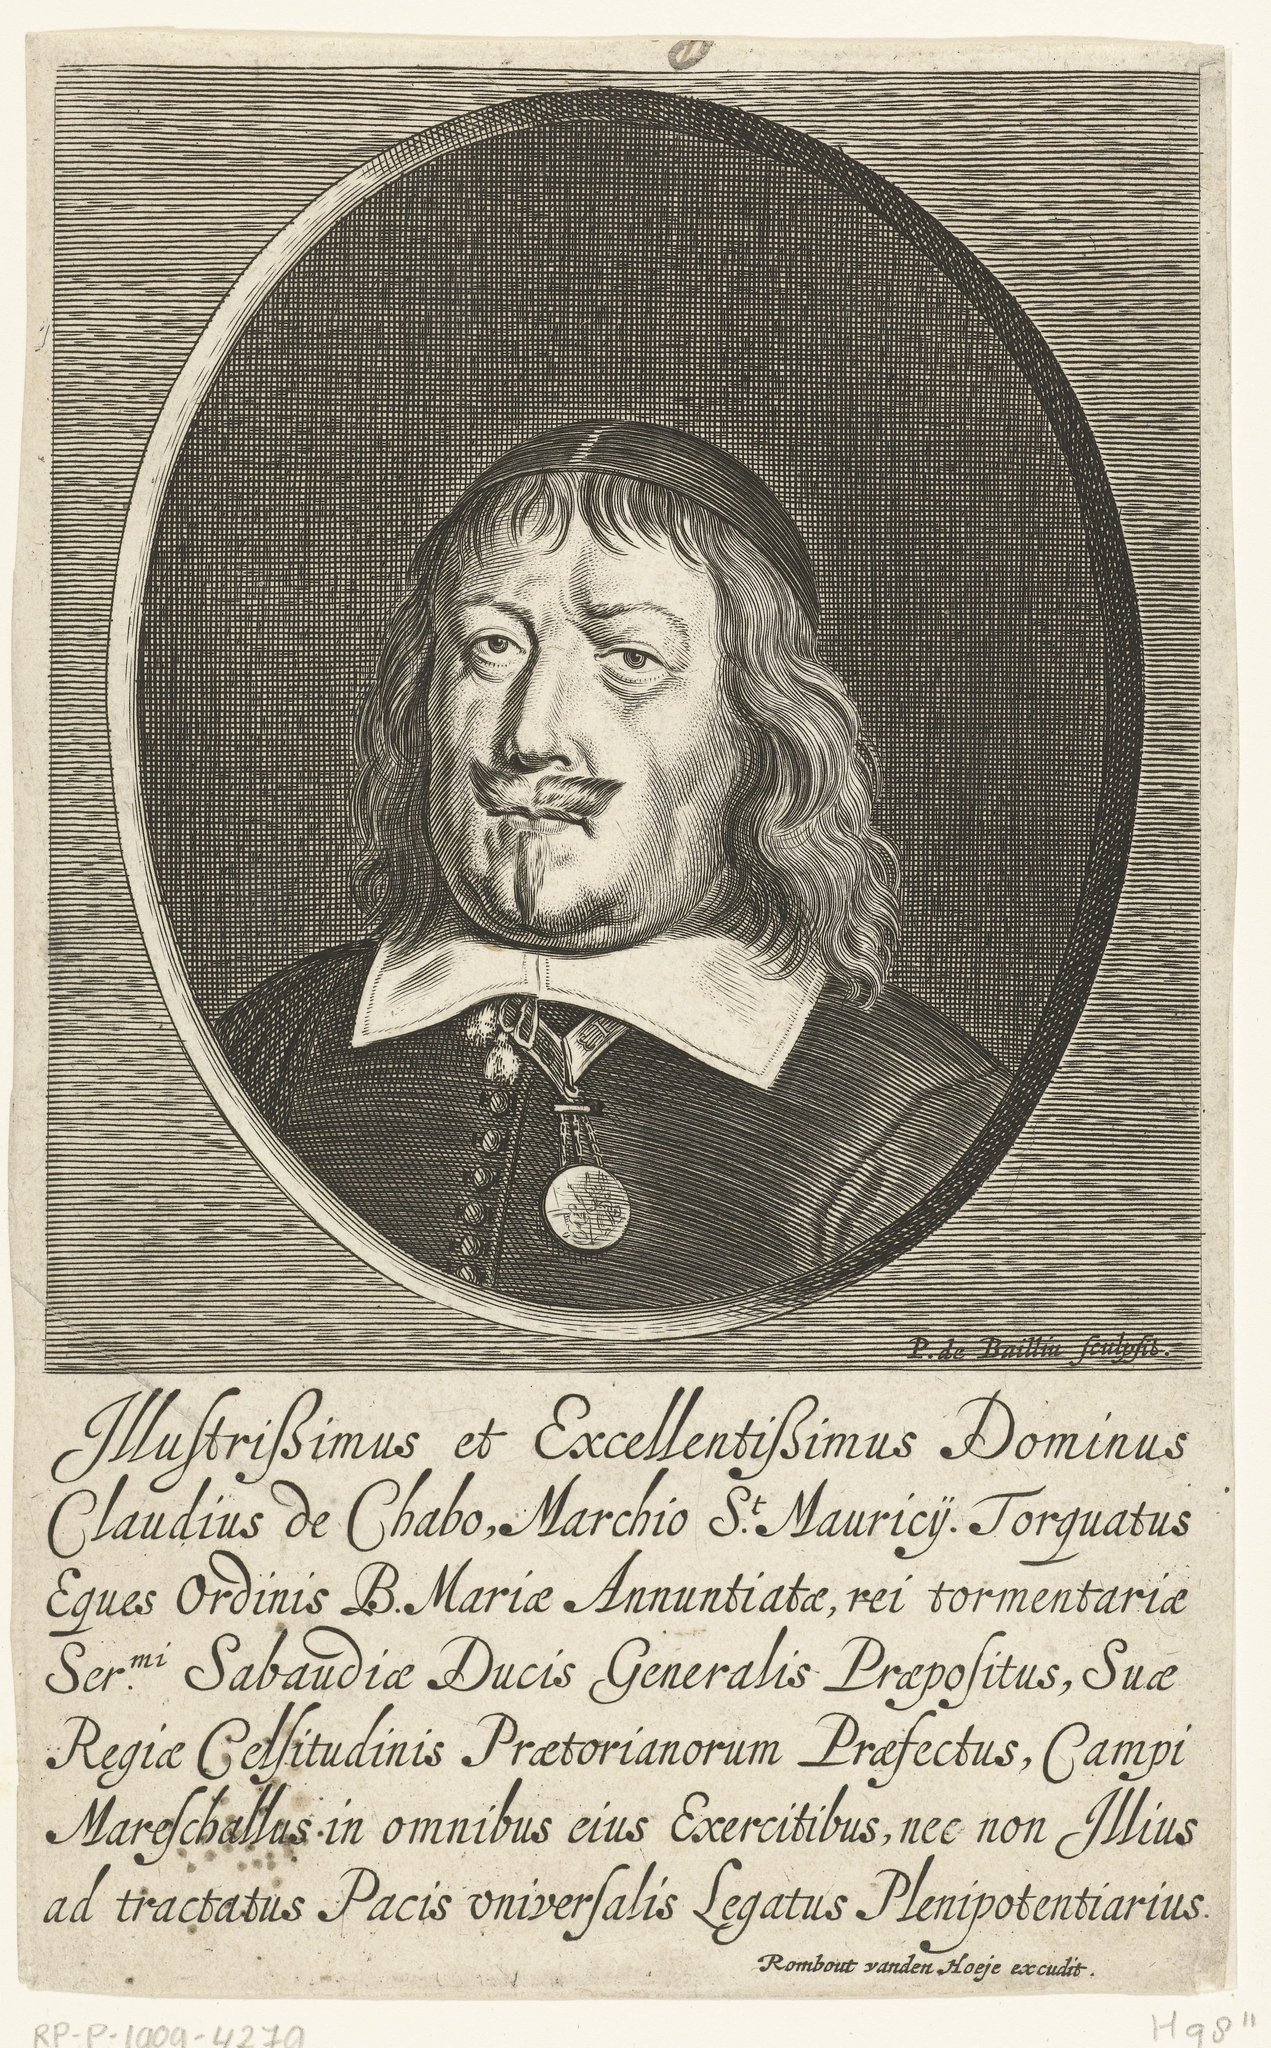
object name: print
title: Portret van Claude de Chabot markies van Sint Mauritius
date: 1623-1660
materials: paper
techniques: engraving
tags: claude de chabot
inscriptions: collector's mark: Lugt 2228